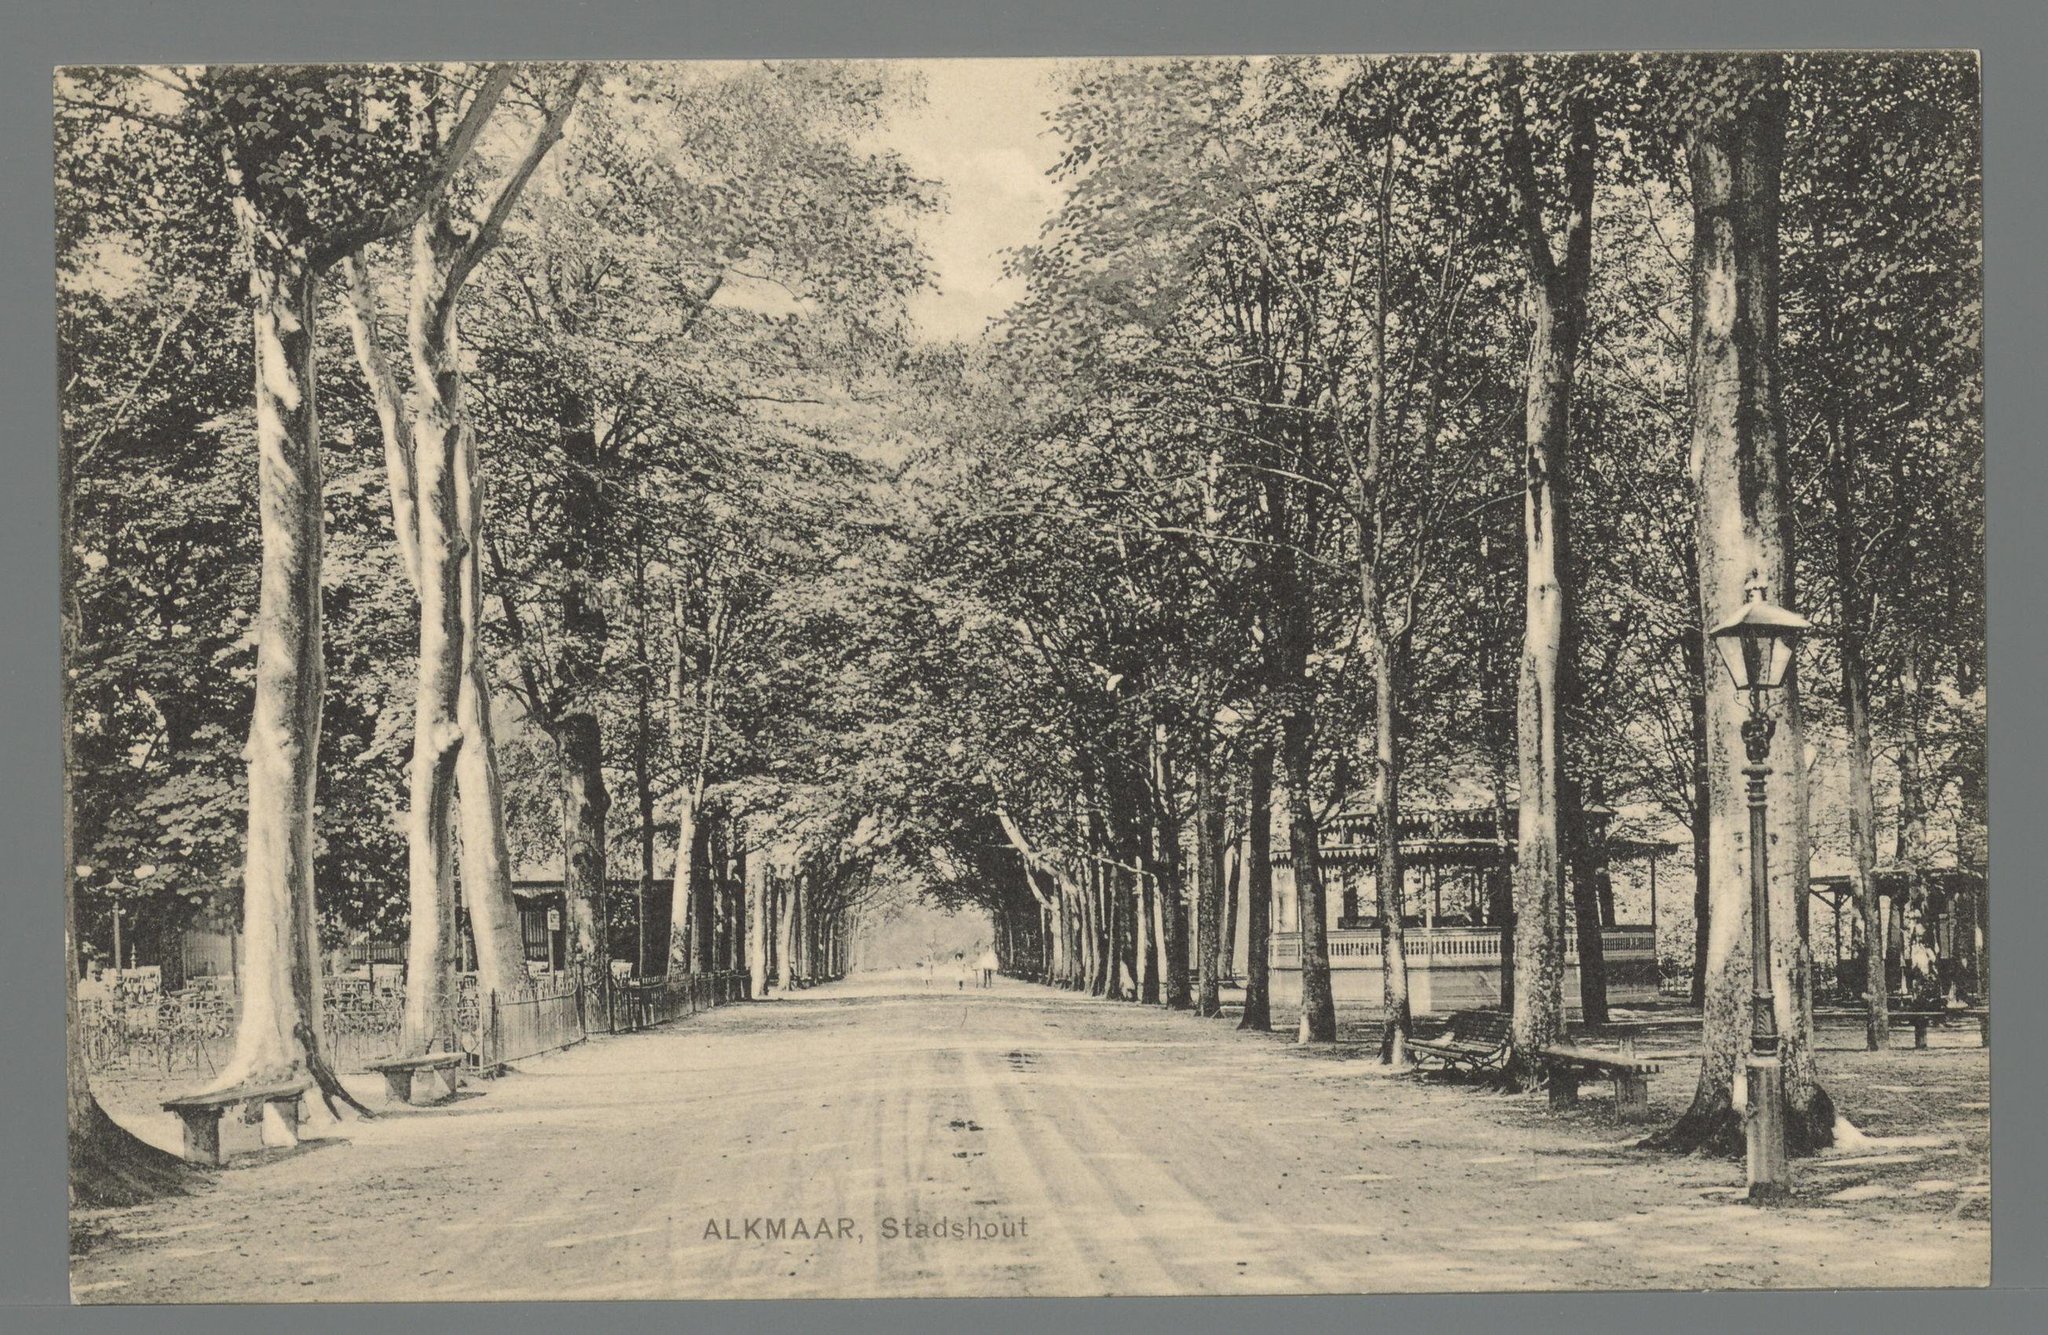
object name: ansichtkaart, prentbriefkaart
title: Alkmaar, Stadshout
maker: Anonymous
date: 1906-1930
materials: cardboard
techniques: photograph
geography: alkmaar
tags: forest, wood, street lighting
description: Mogelijk gedateerd 1919 op verso, eerste twee cijfers van het getal.